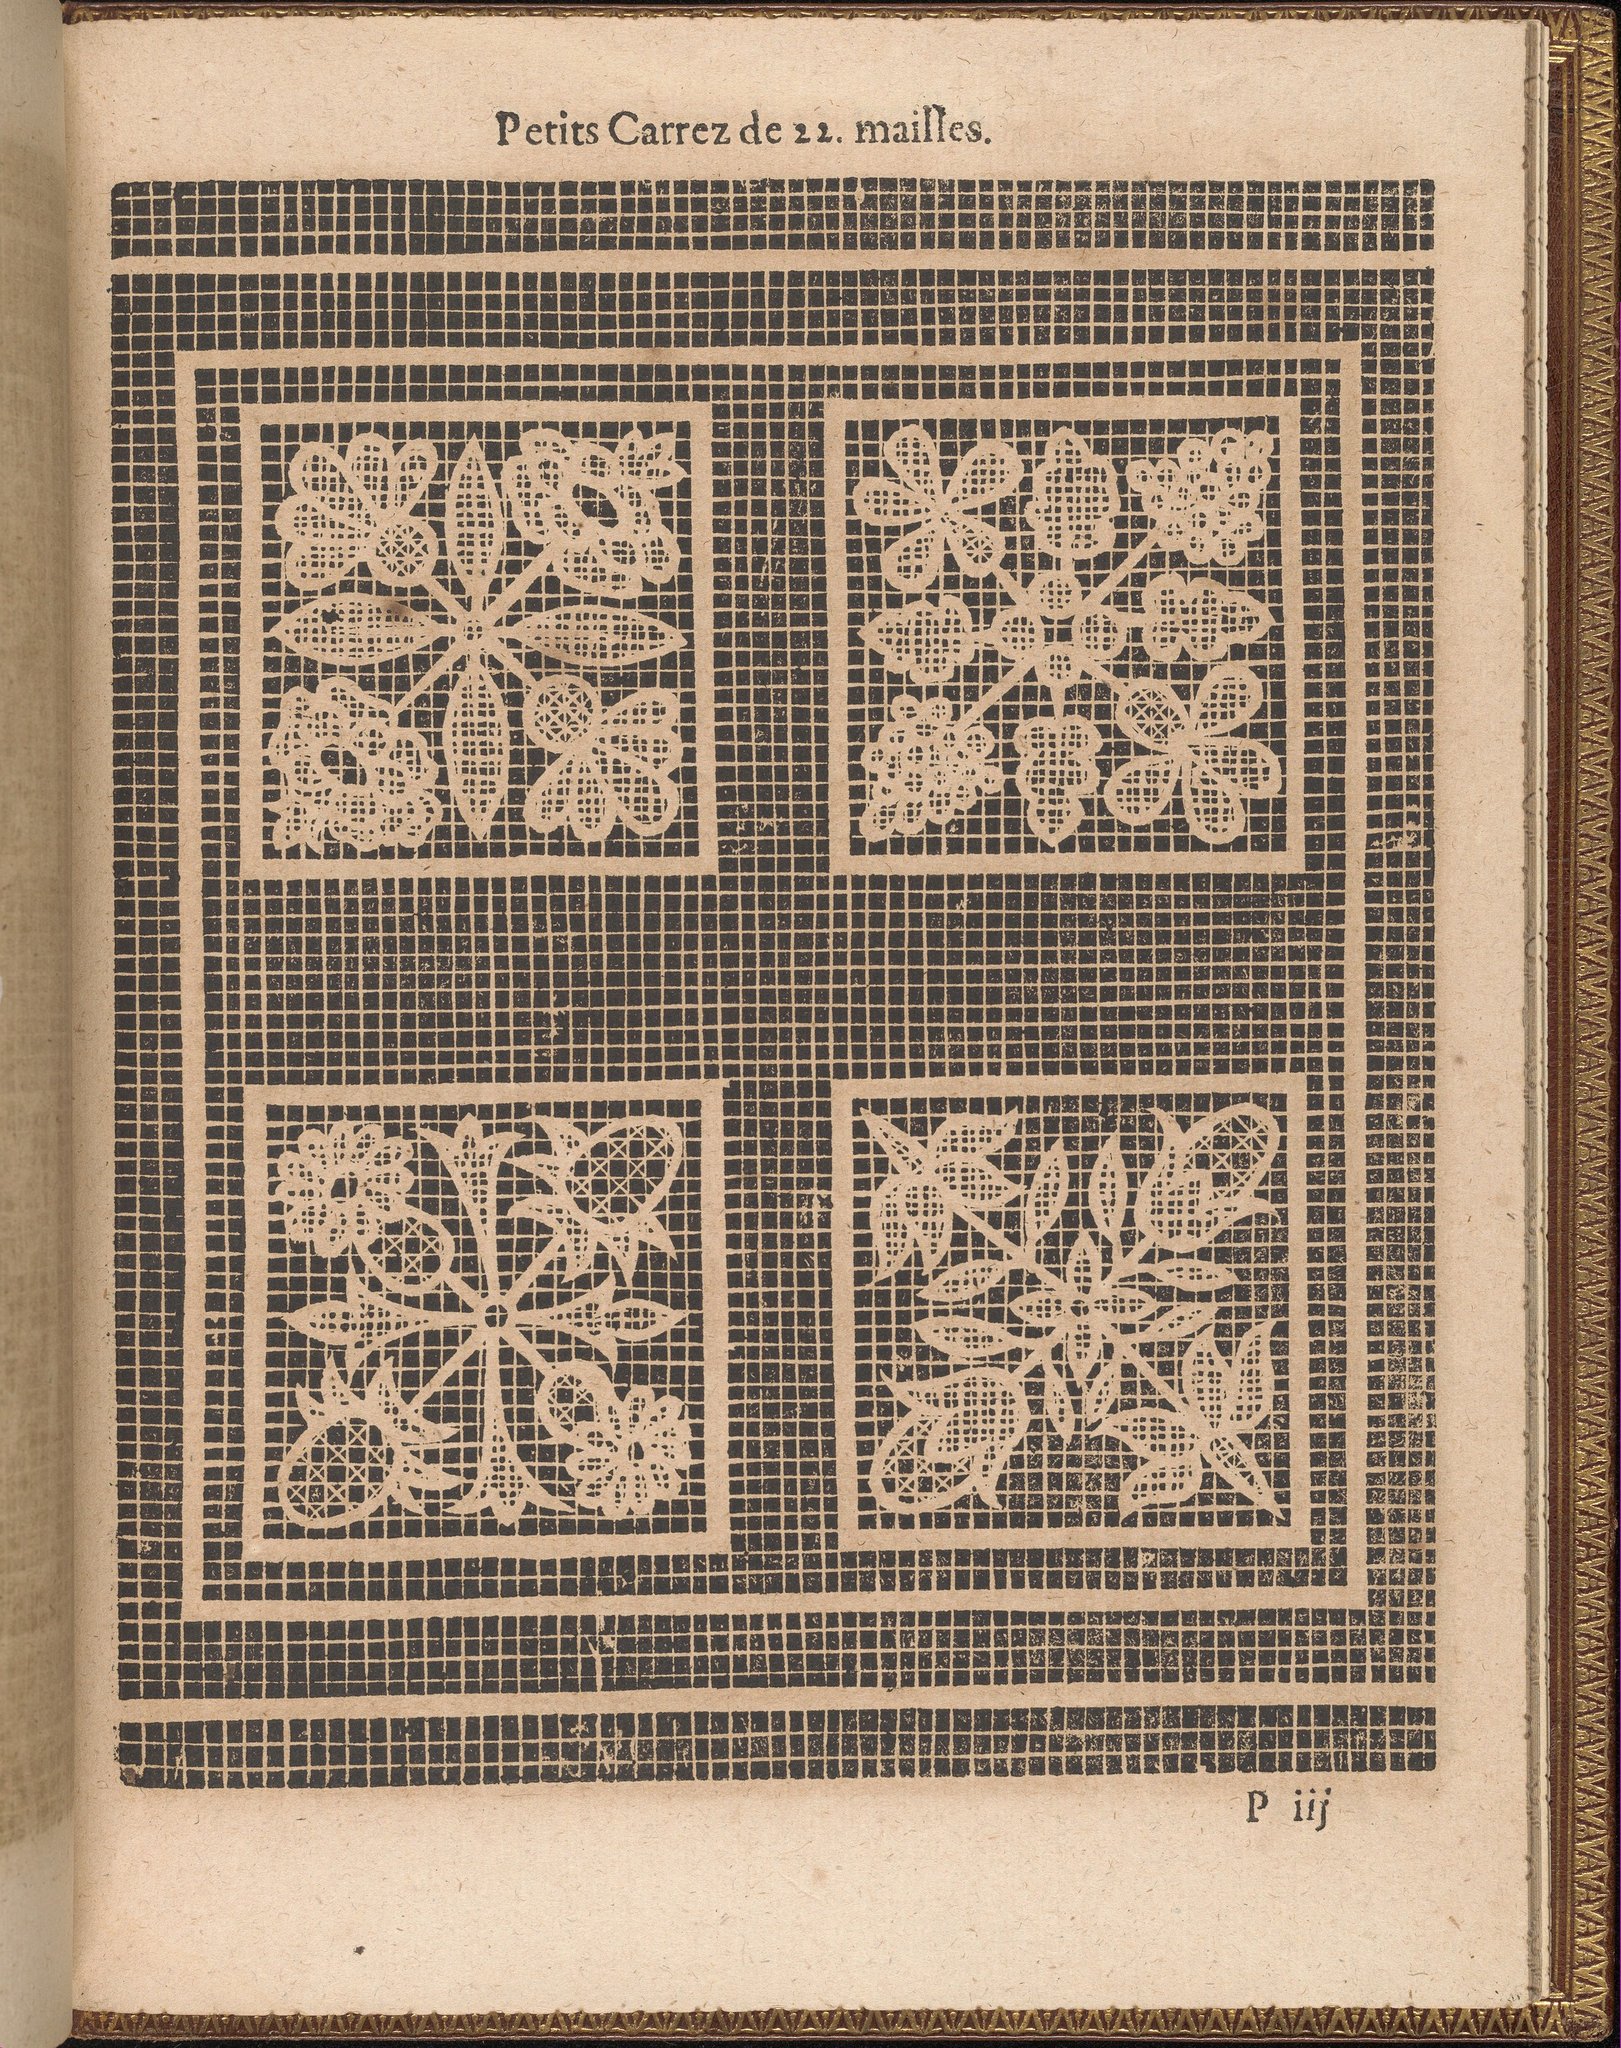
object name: book print ornament architecture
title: La Pratique de l'Aiguille, page 58 (recto)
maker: matthias mignerak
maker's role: author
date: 1605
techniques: woodcut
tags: ornament